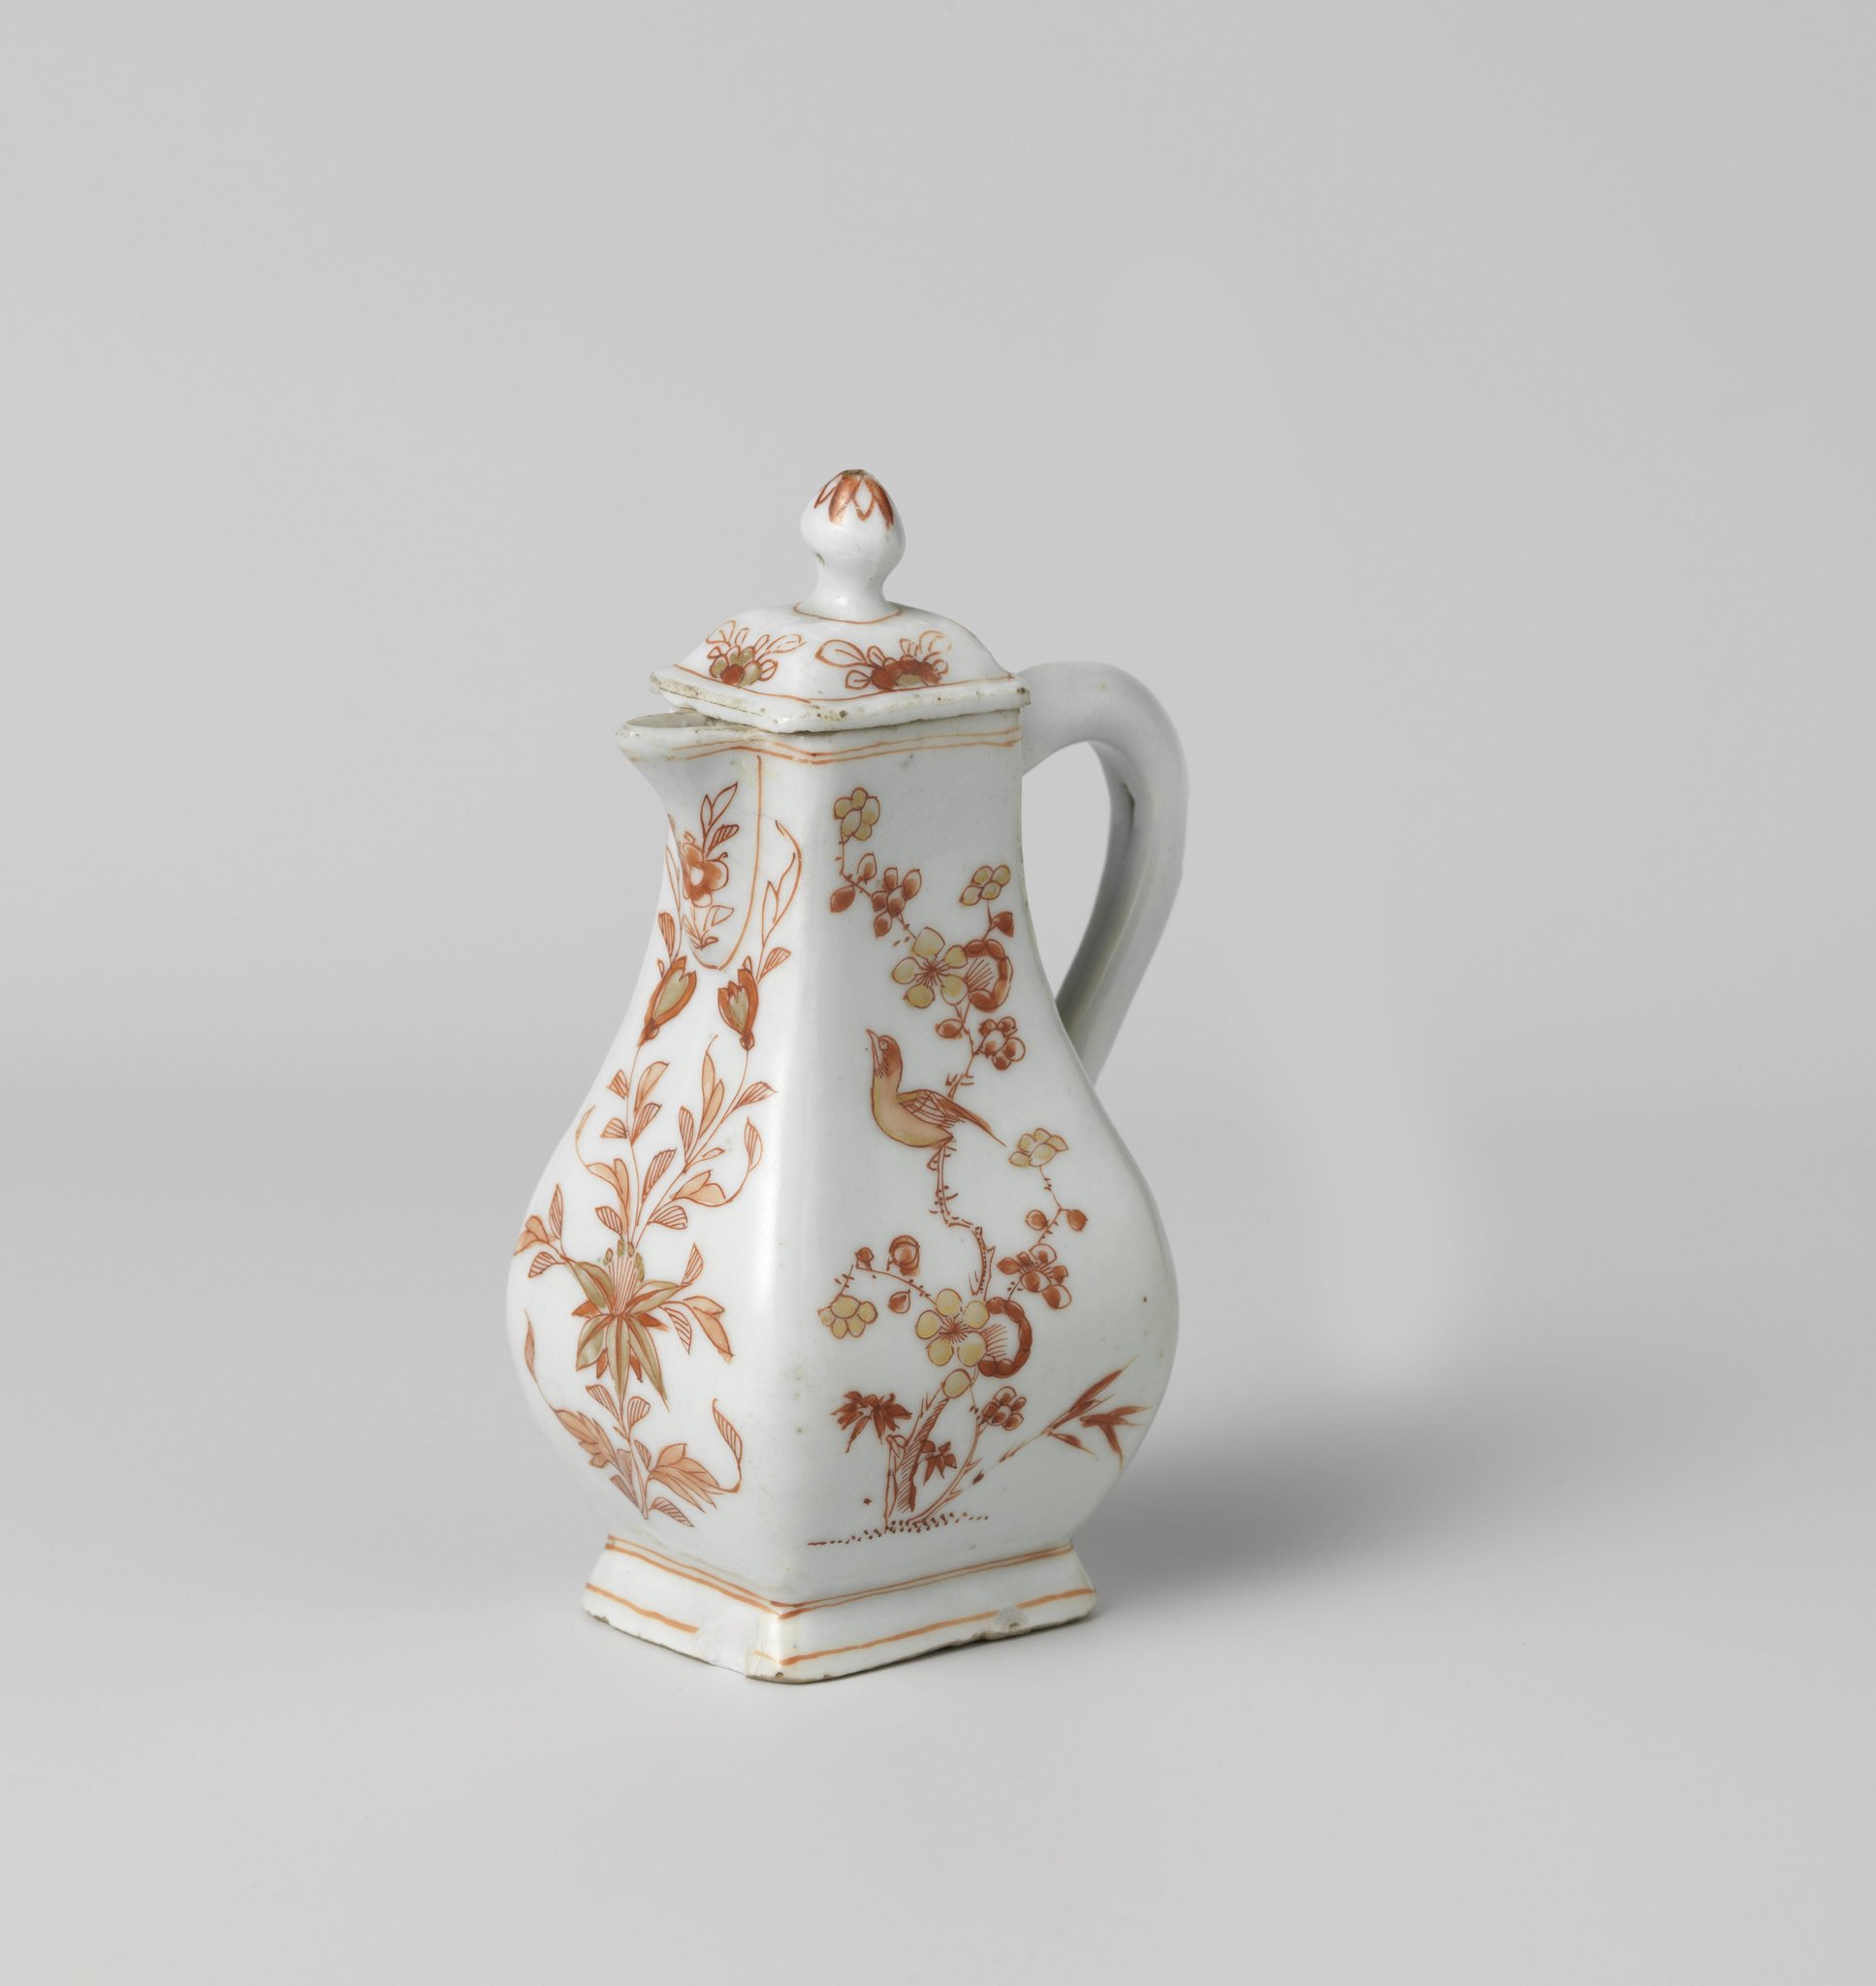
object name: milk jug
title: Square pear-shaped milk jug with flower sprays, butterflies and birds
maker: Anonymous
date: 1700-1724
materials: glaze, gold, paint, porcelain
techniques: firing, gilding, turning, vitrification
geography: china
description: Kan, melk en bloed, vierkant, wit met rood en geel voorstelling van een bloementak met een vogel.